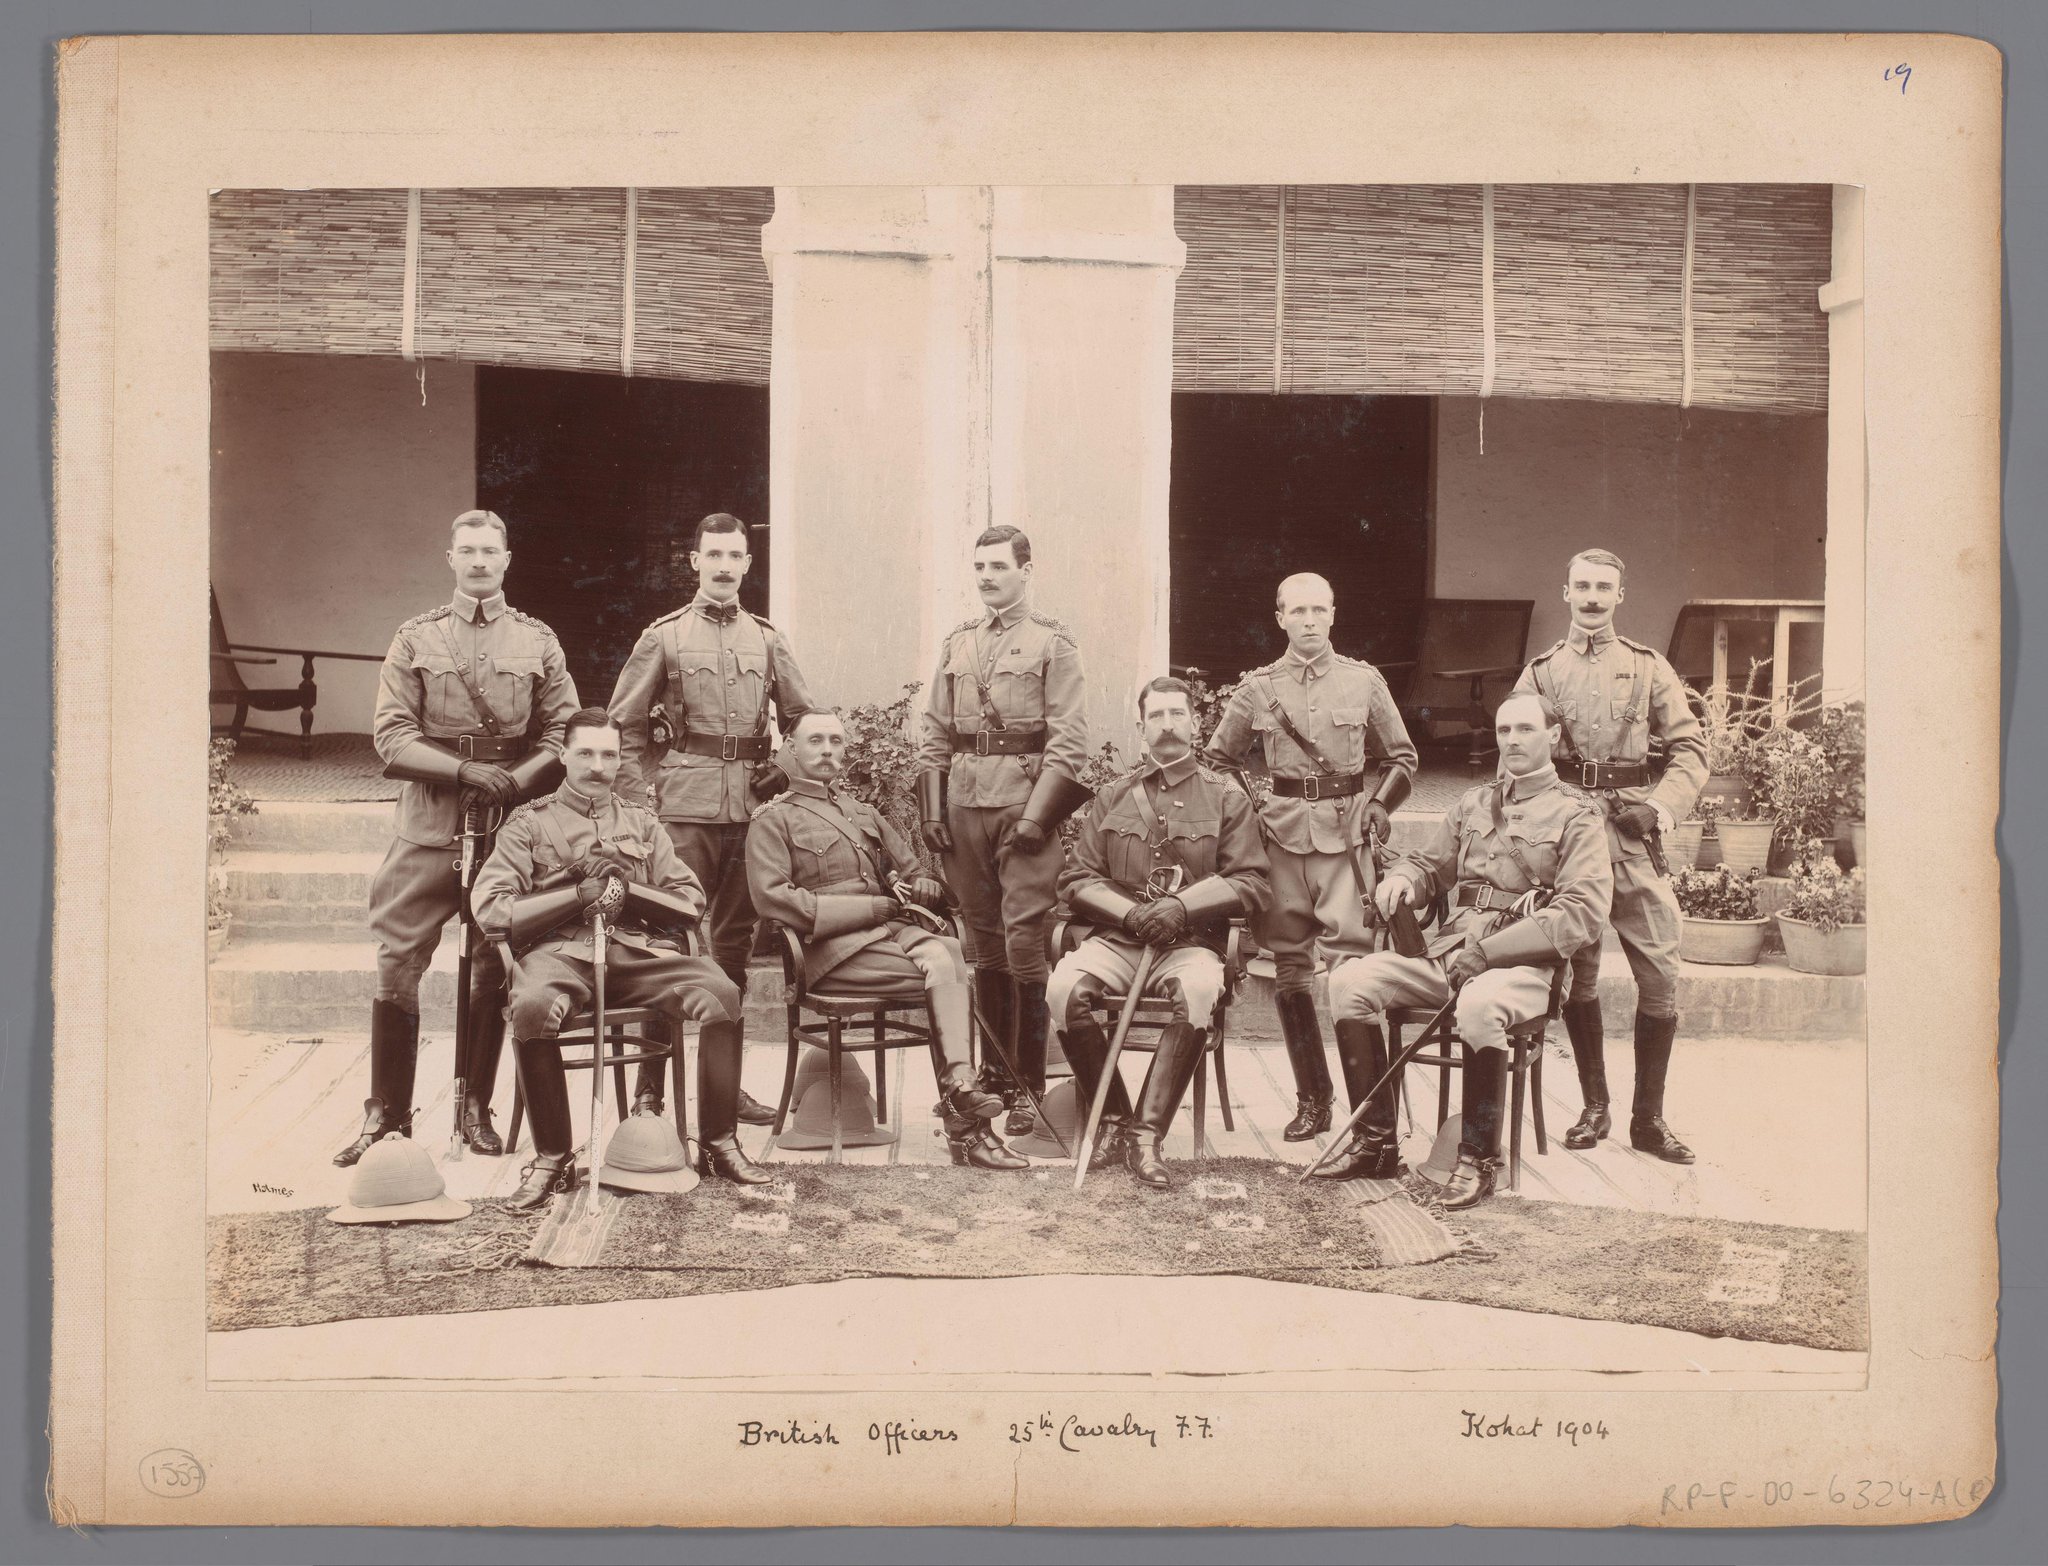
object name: album leaf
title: British officers, Kohat, Pakistan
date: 1904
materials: cardboard, paper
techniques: gelatin silver print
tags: pakistan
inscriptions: number: ‘19’, title: ‘British officers 25th Cavalry 7.7. Kohat 1904’, signature: ‘Holmes’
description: Negen officieren van het Britse leger in uniform van het 25. Cavalry 7.7. zittend en staand voor een huis, Kohat, Pakistan